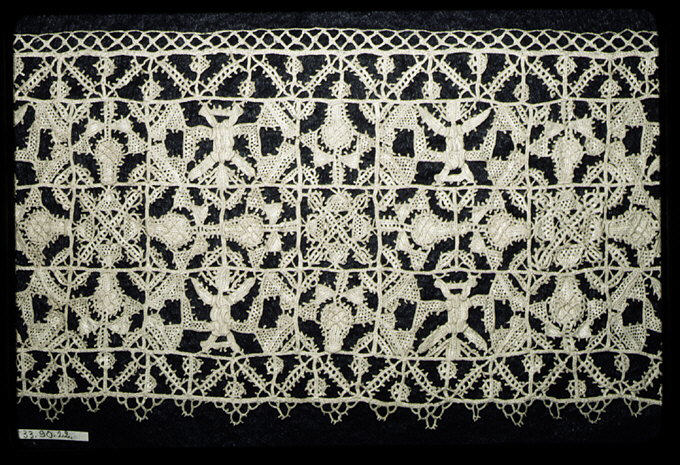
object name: border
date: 1601-1700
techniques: lace